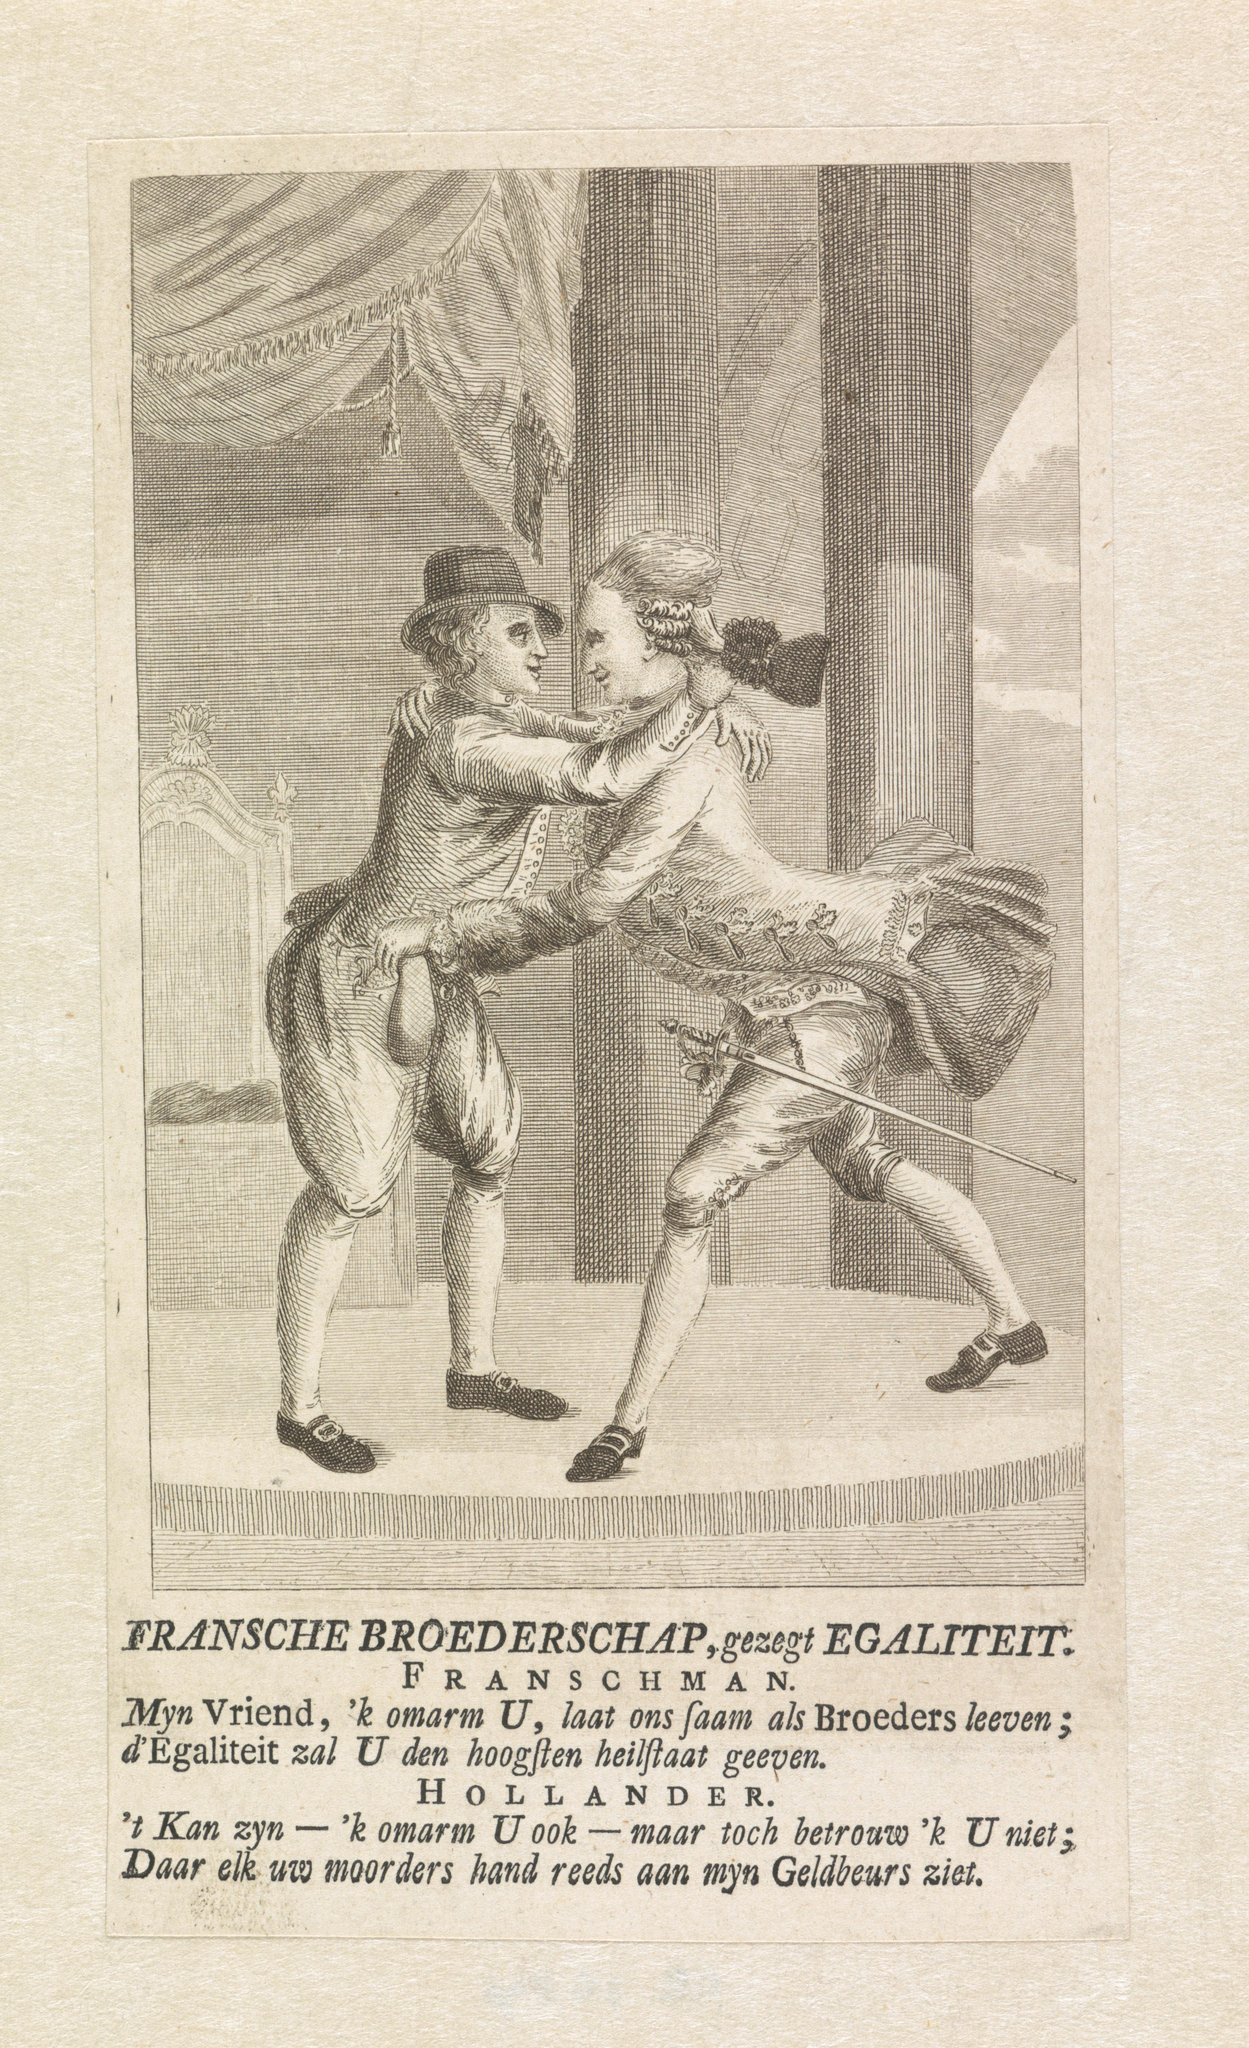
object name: cartoon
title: Fransche Broederschap, gezegt Egaliteit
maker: Anonymous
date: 1793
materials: paper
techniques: engraving, etching, letterpress printing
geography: netherlands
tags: brotherly love, pickpocket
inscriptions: collector's mark: Lugt 2228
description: Spotprent op de Franse broederschap, 1793. Een Fransman en Hollander omarmen elkaar terwijl de Fransman de beurs van de Hollander steelt. Waarschijnlijk naar aanleiding van de eerste Franse inval in 1793. In het onderschrift een samenspraak tussen de twee.